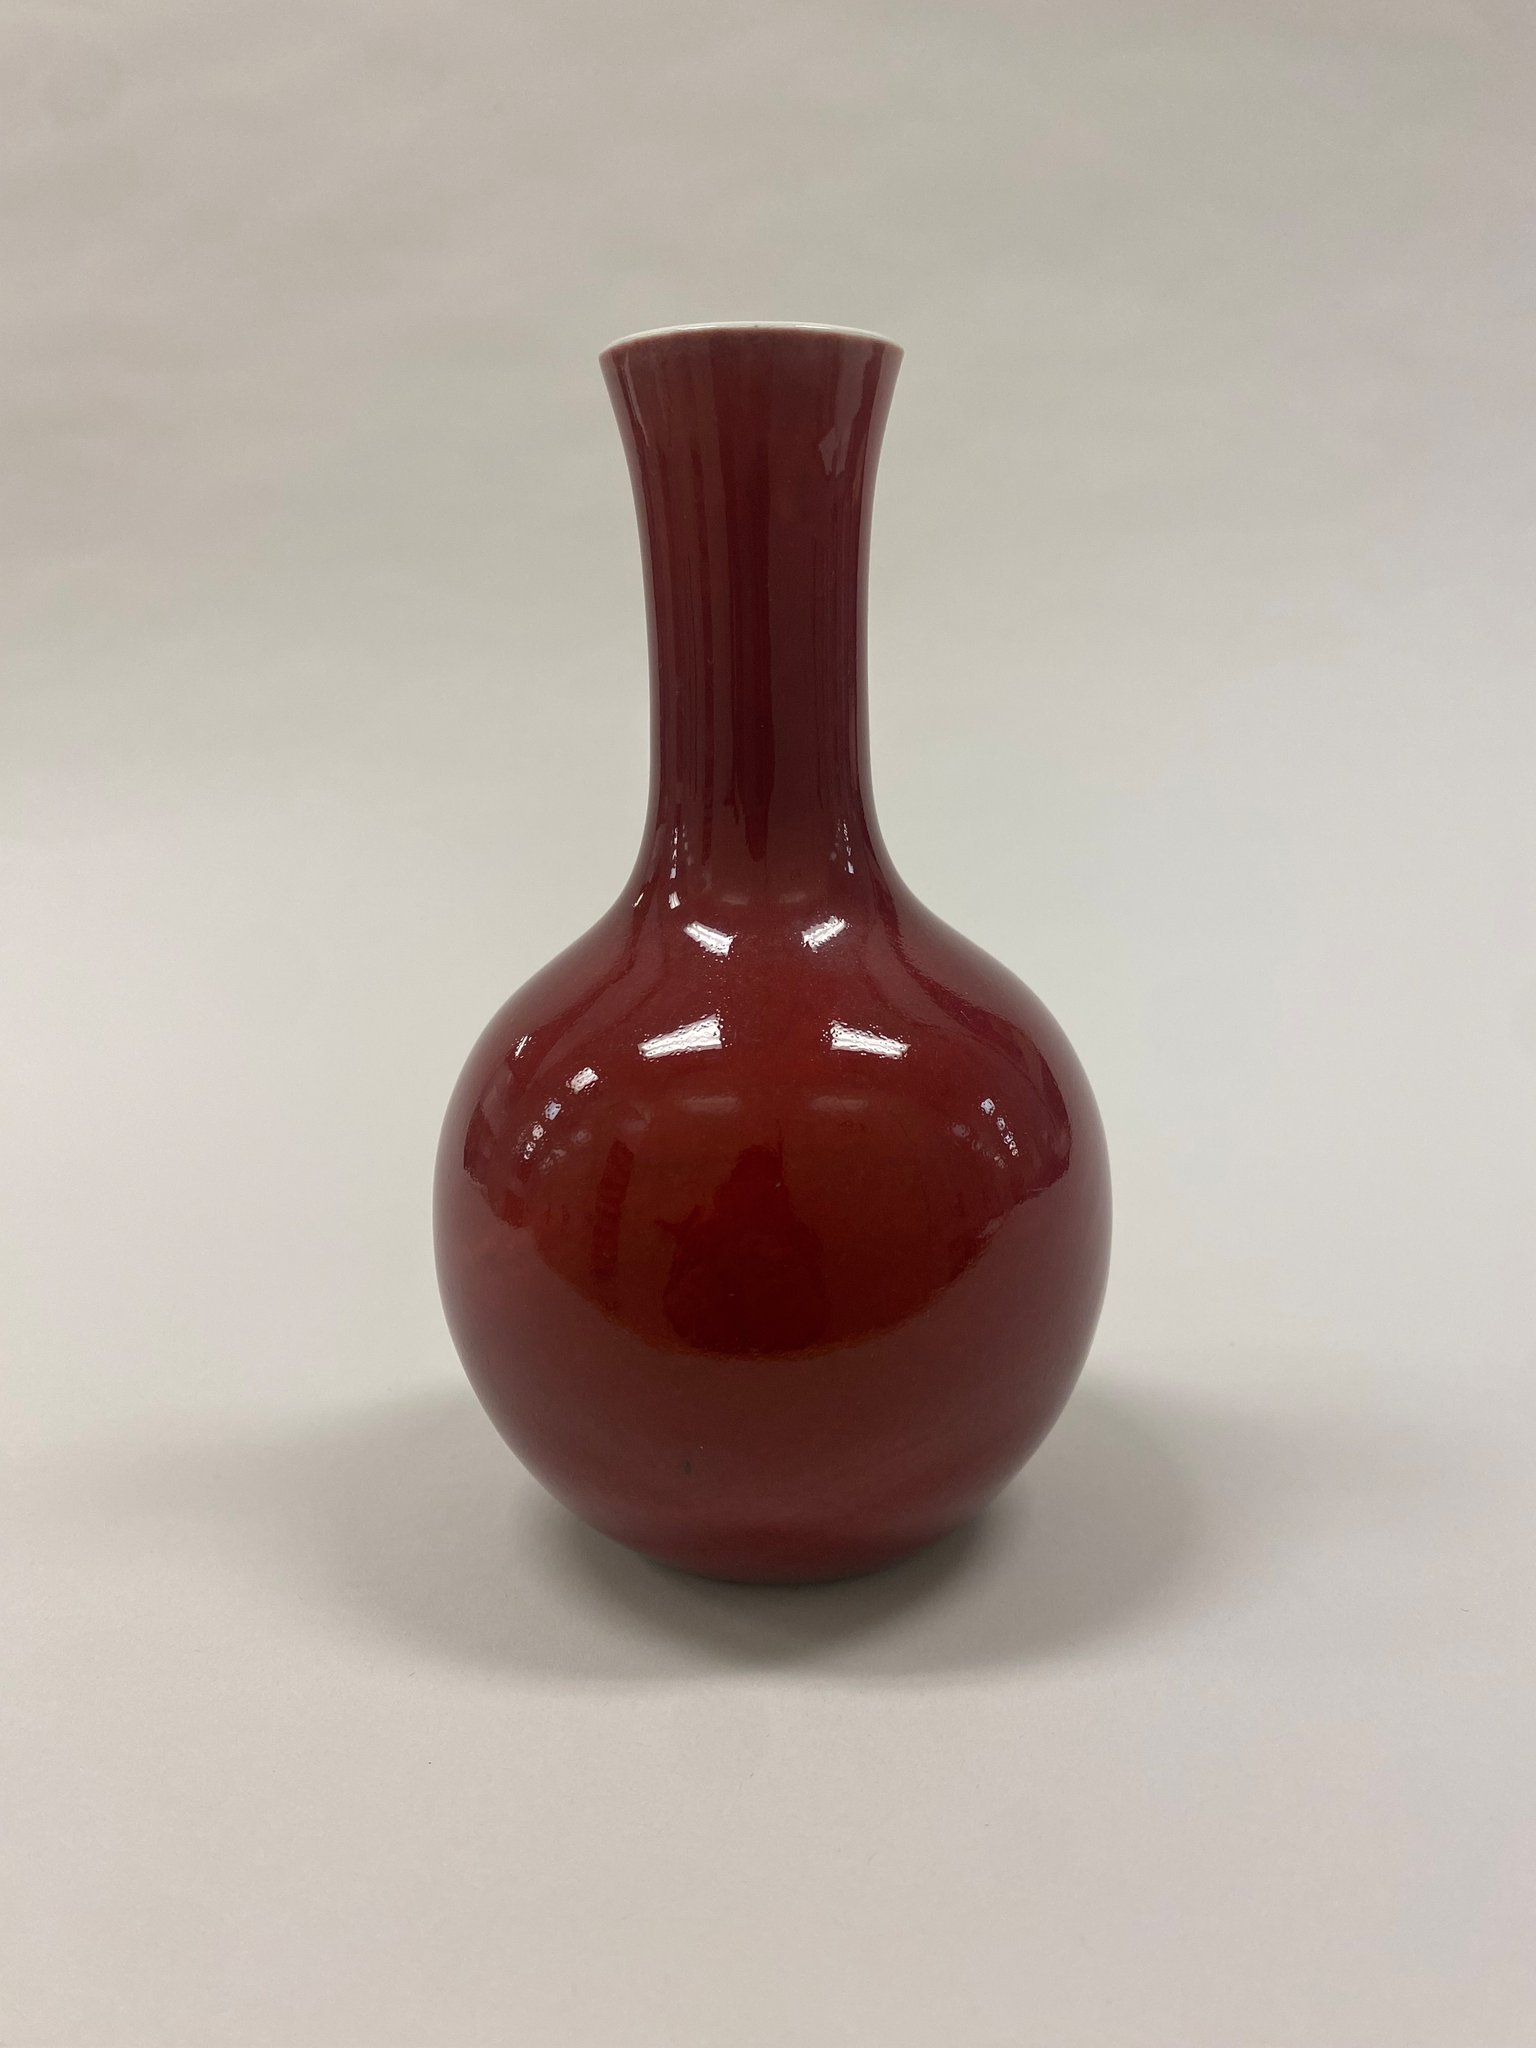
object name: vase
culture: chinese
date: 1701-1800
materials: copper, glaze, porcelain